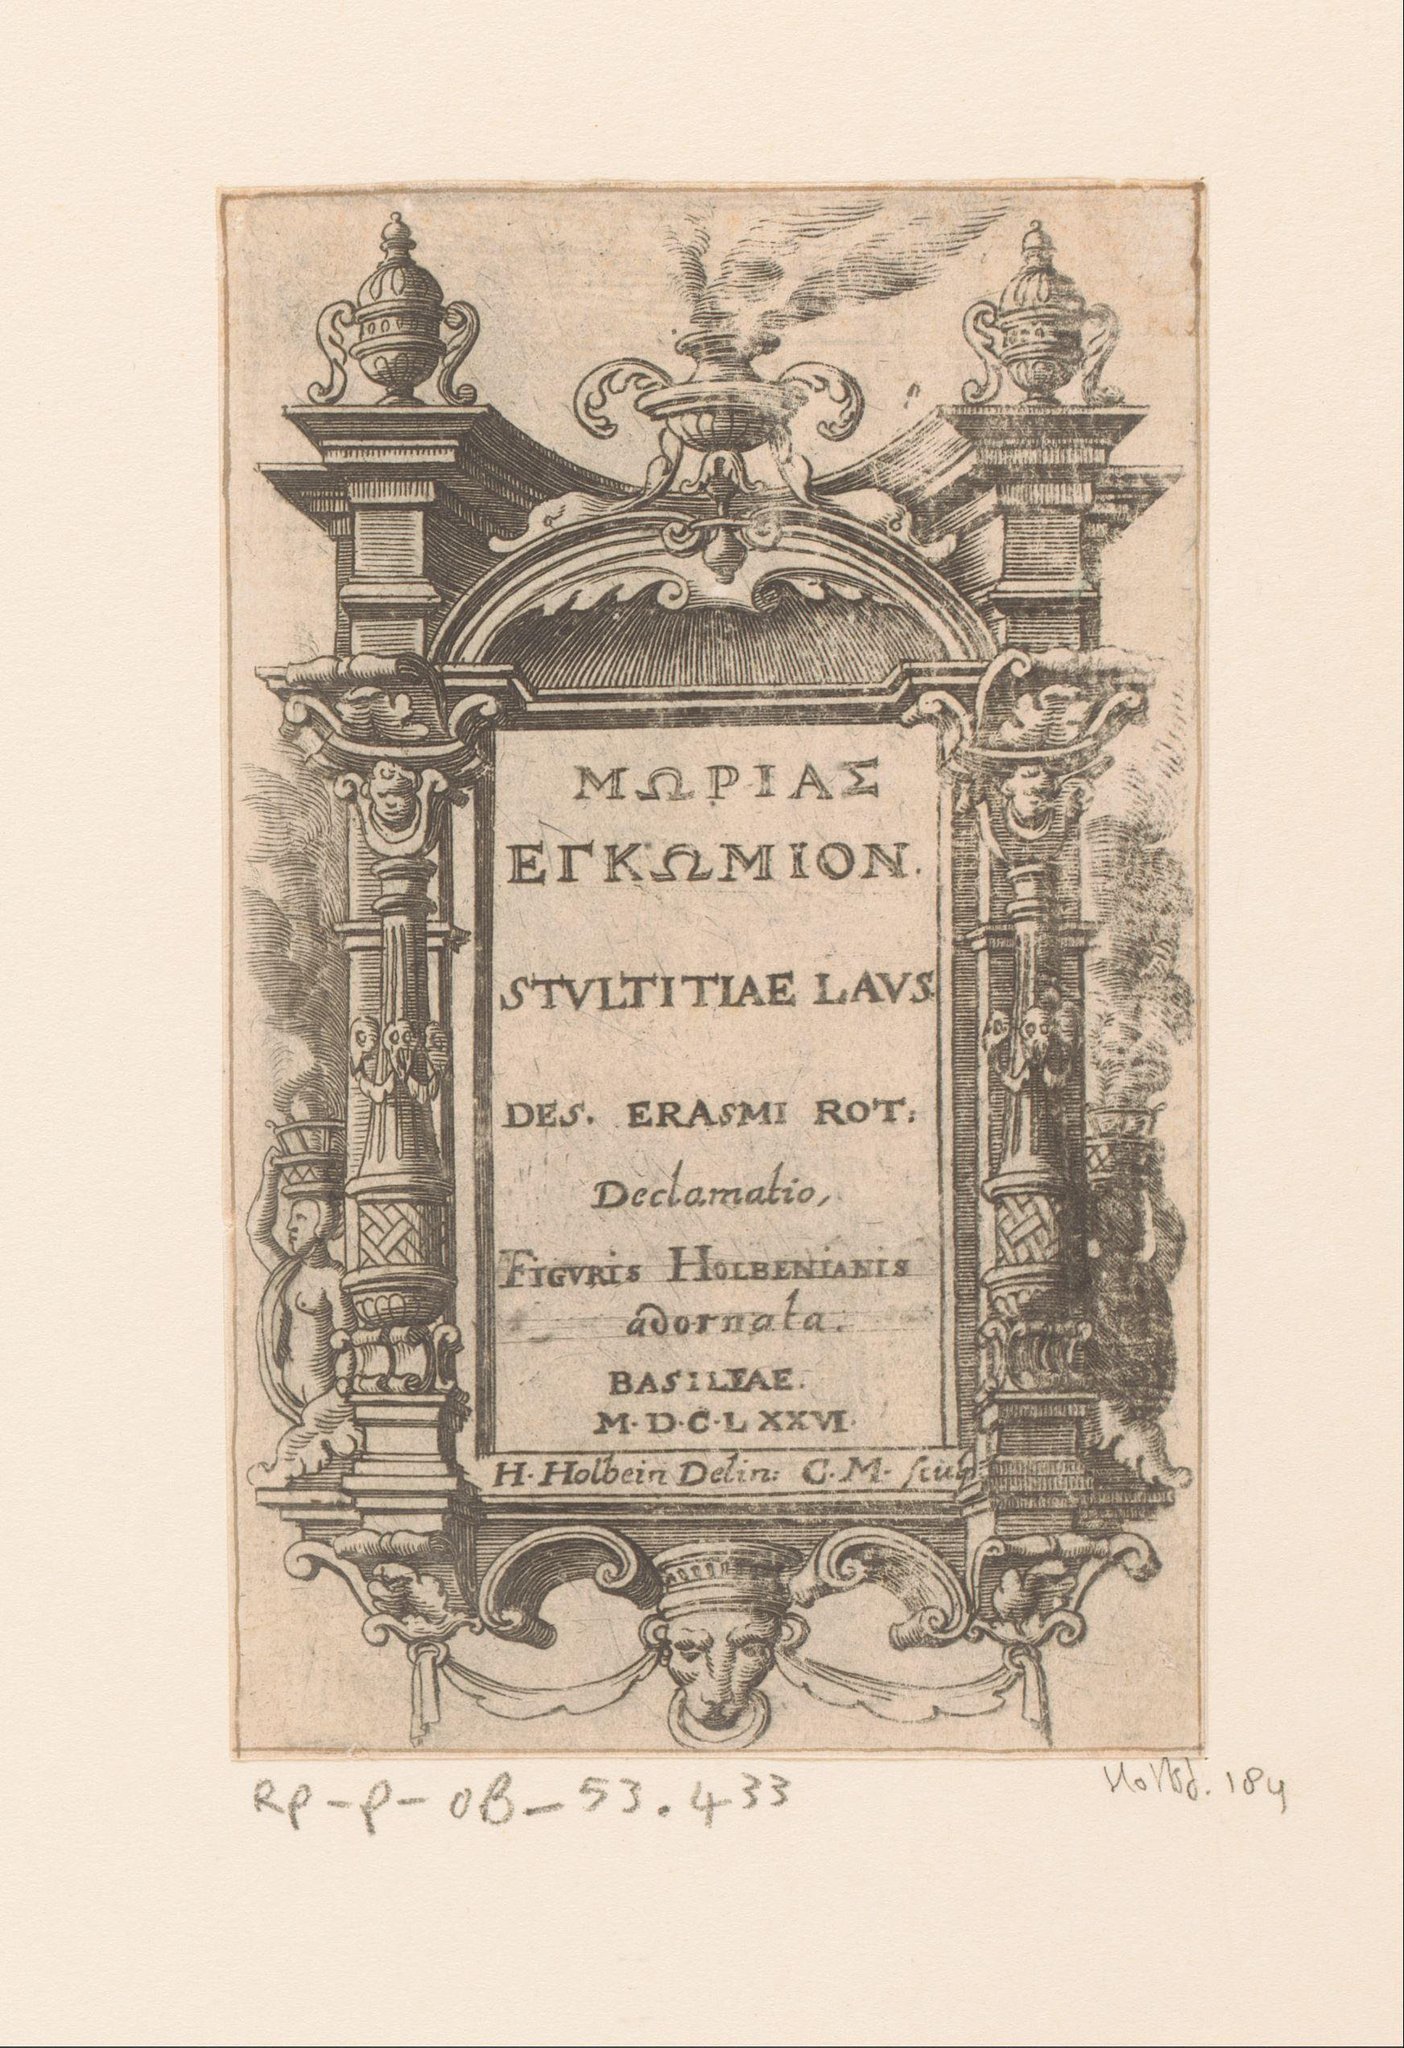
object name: titelblad, titelpagina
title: Architectonische omlijsting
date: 1676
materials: paper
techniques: engraving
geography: basel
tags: title-page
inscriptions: collector's mark: Lugt 2228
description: Titelpagina voor: Erasmus, Desiderius. Morias enkomion, stultitiae lavs Des, Erasmi, Rot. Bazel: Charles Patin, 1676.